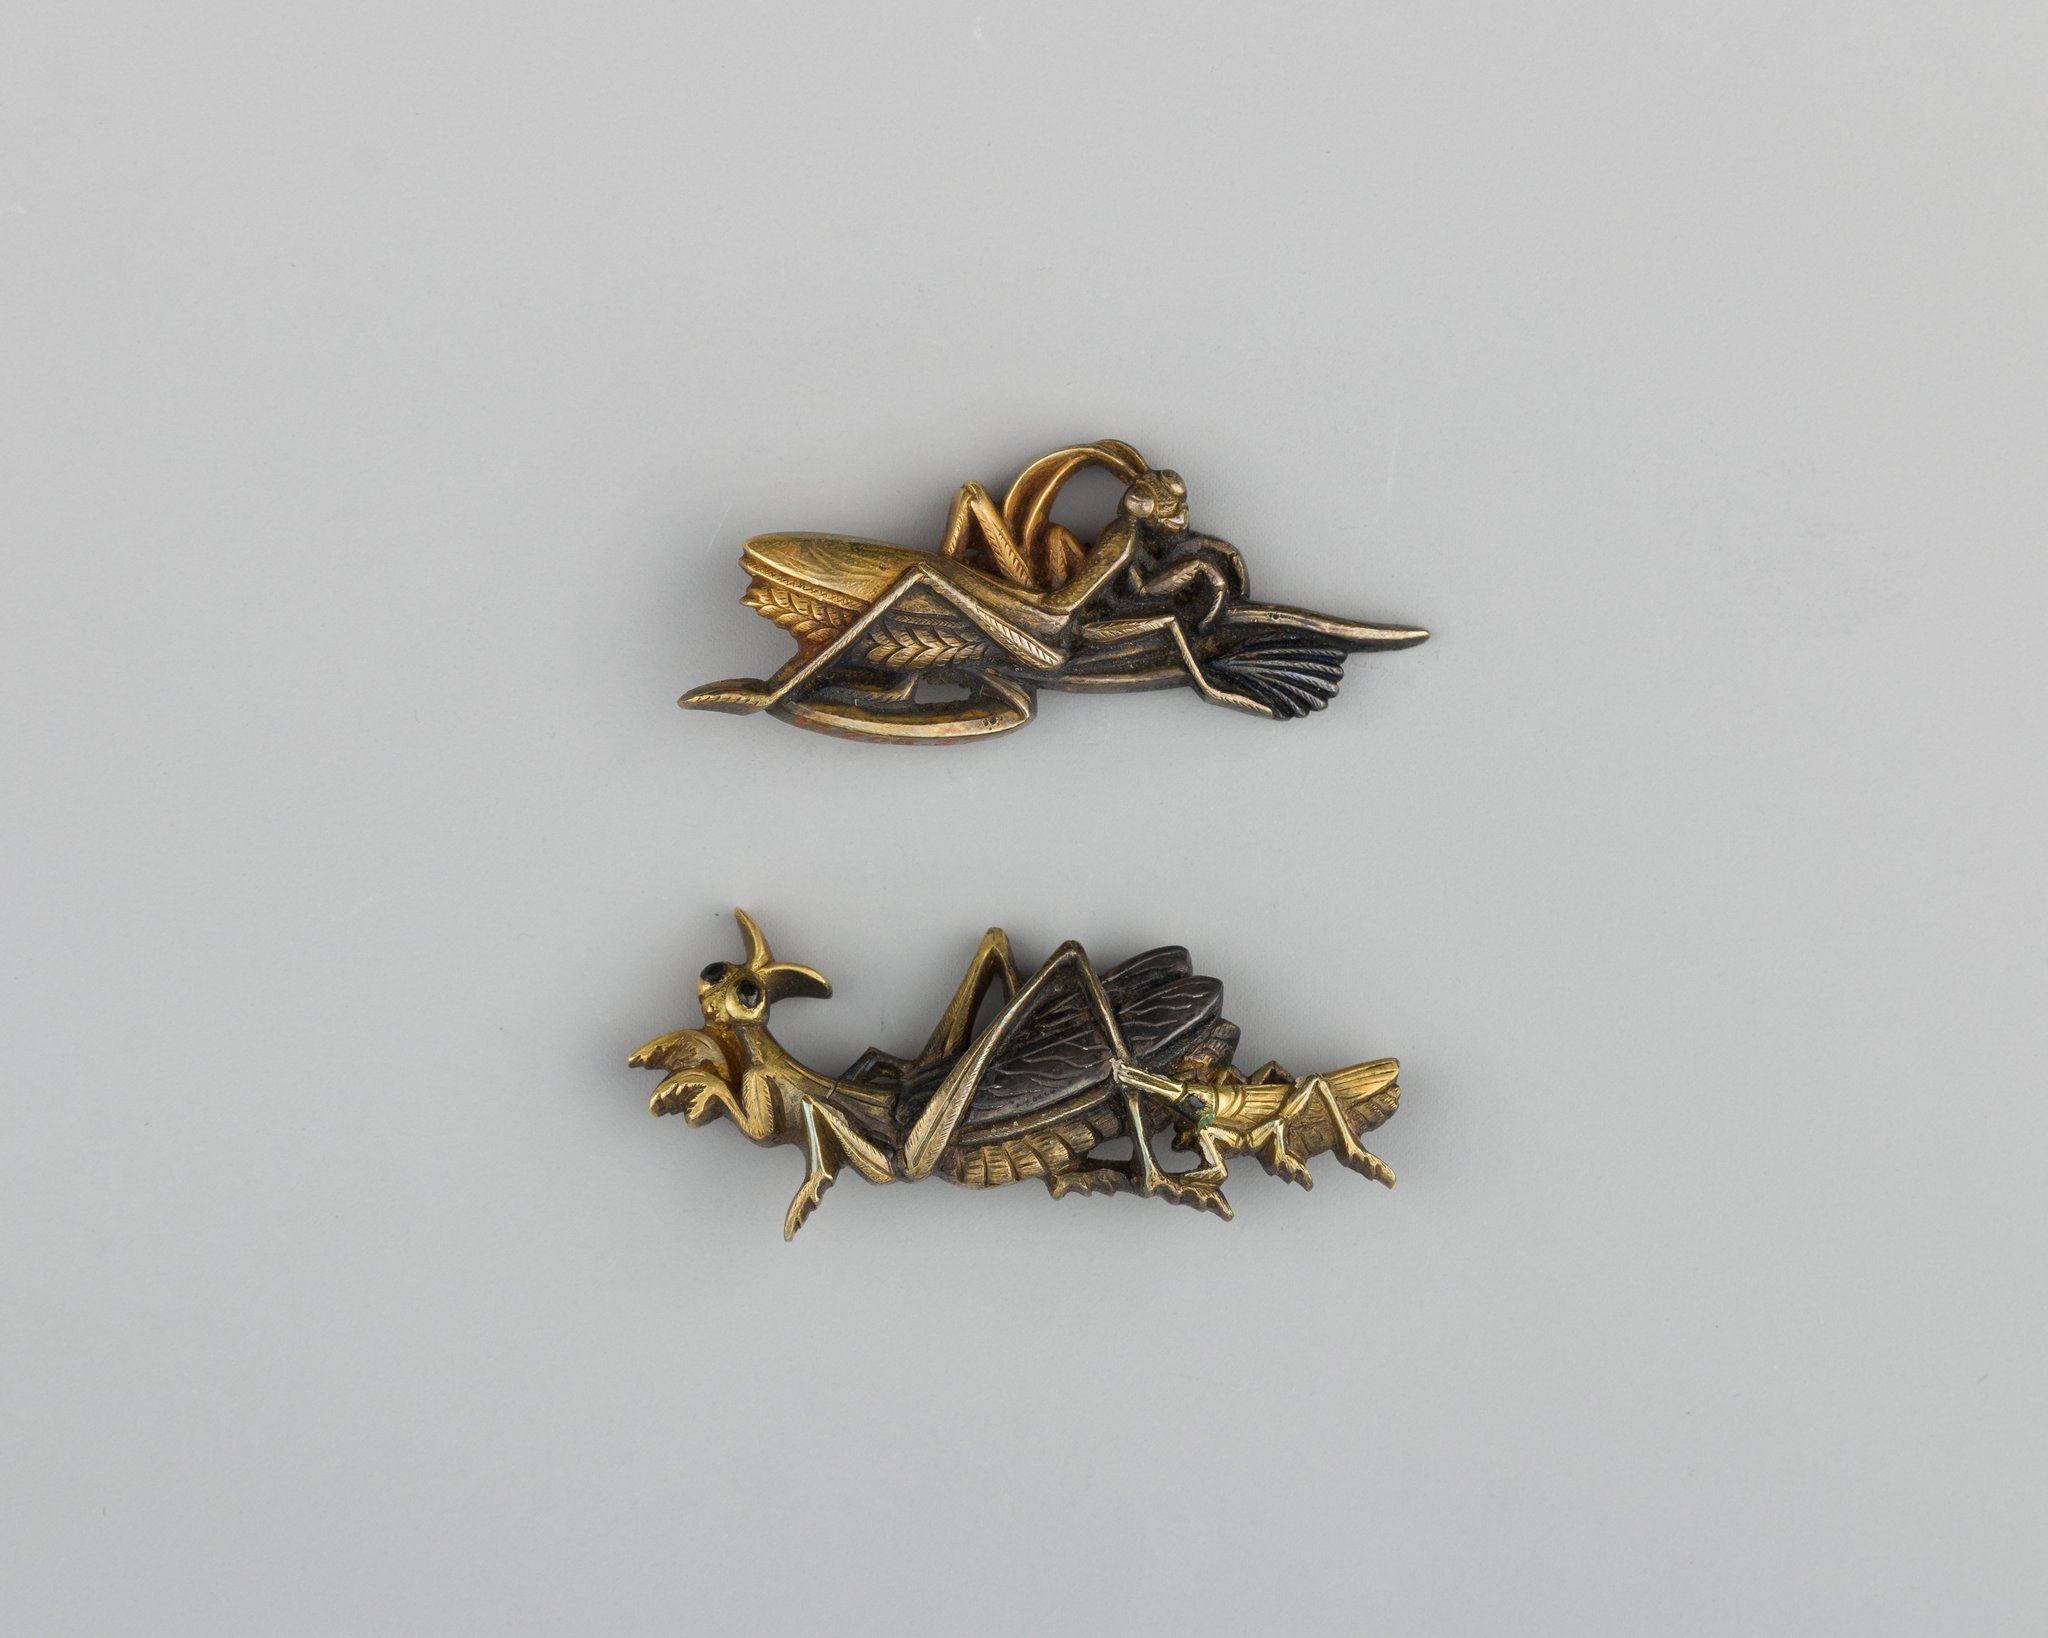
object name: pair of sword grip ornament menuki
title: Pair of Sword-Grip Ornaments (Menuki)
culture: japanese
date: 1701-1800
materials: copper, silver alloy, gold, silver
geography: japan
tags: insects